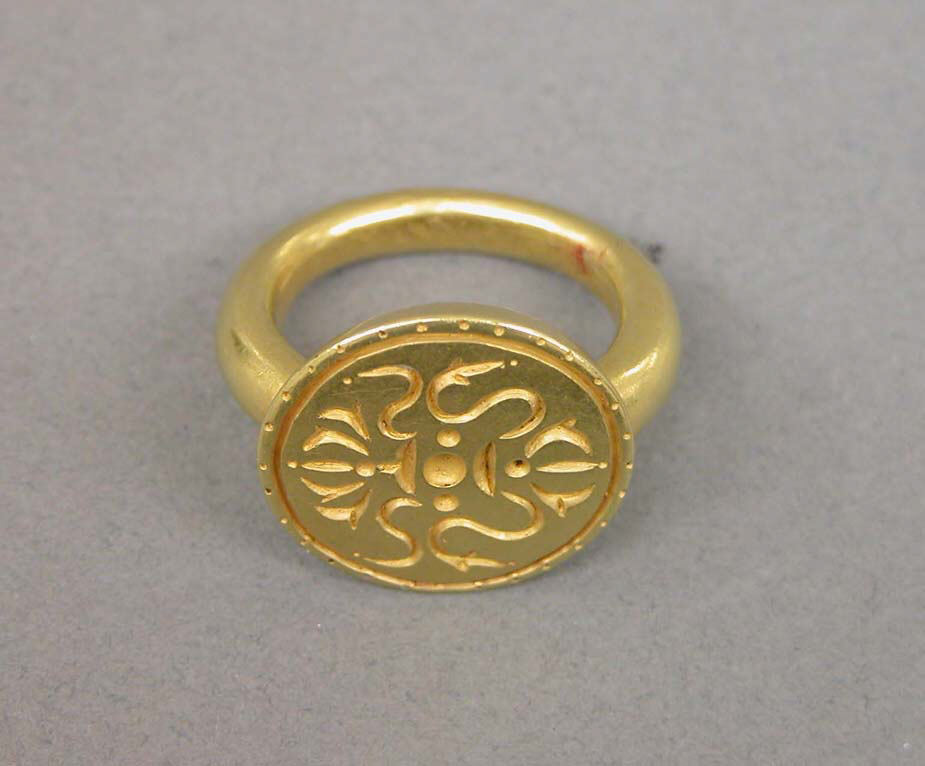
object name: ring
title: Ring with Circular Bezel and "Sri" Inscription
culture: indonesian, javanese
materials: gold